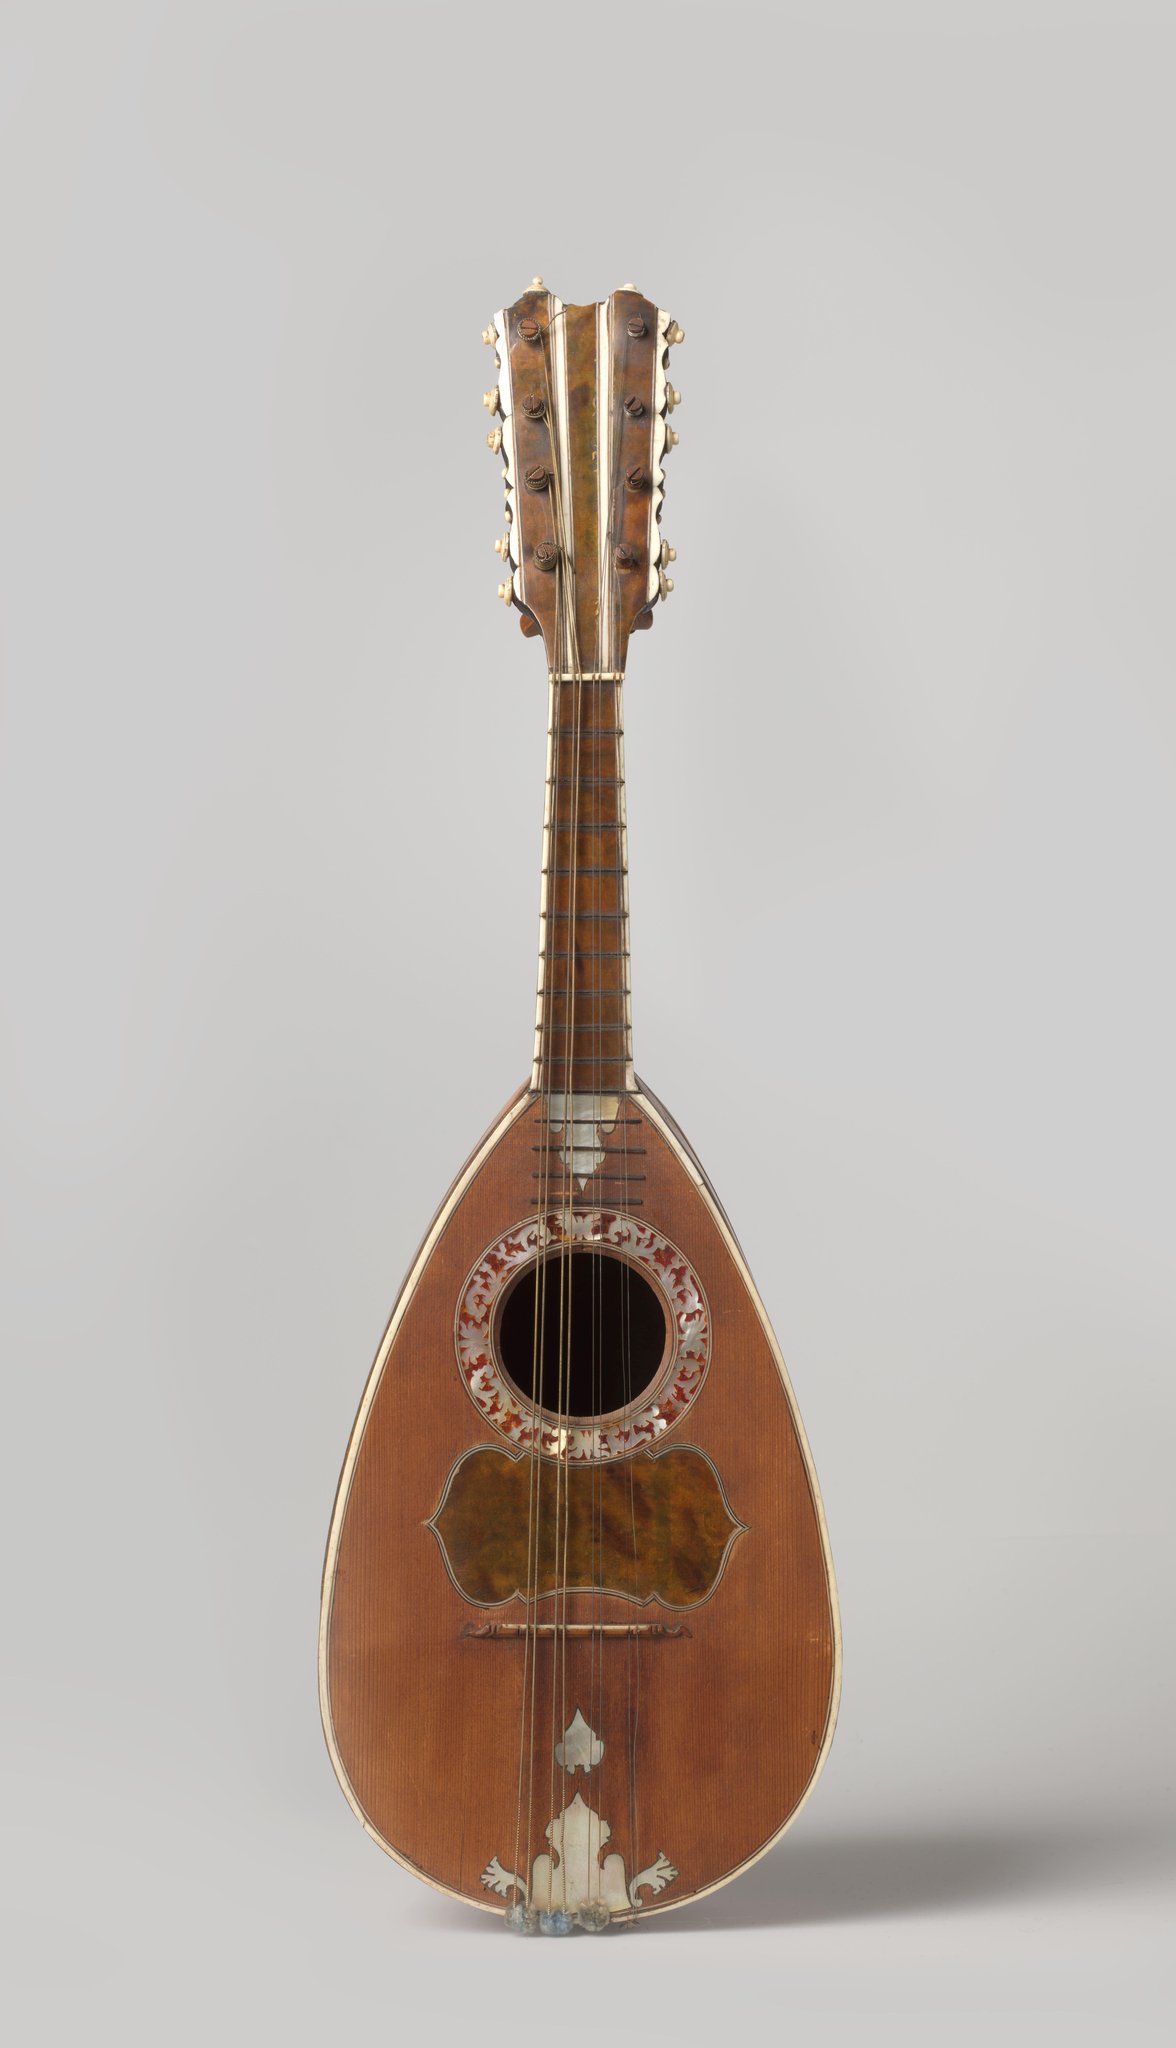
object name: stringed instrument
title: Neapolitan mandolin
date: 1770-1780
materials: bone, metal, mother of pearl, shell, wood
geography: naples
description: This type of mandolin was invented in Naples in the mid-18th century. Its strings are grouped in four pairs and tuned in fifths to the same pitches as the violin. In addition, its fingerboard is fretted to facilitate intonation, which made the mandolin easier to play than the violin and particularly successful among amateur performers.